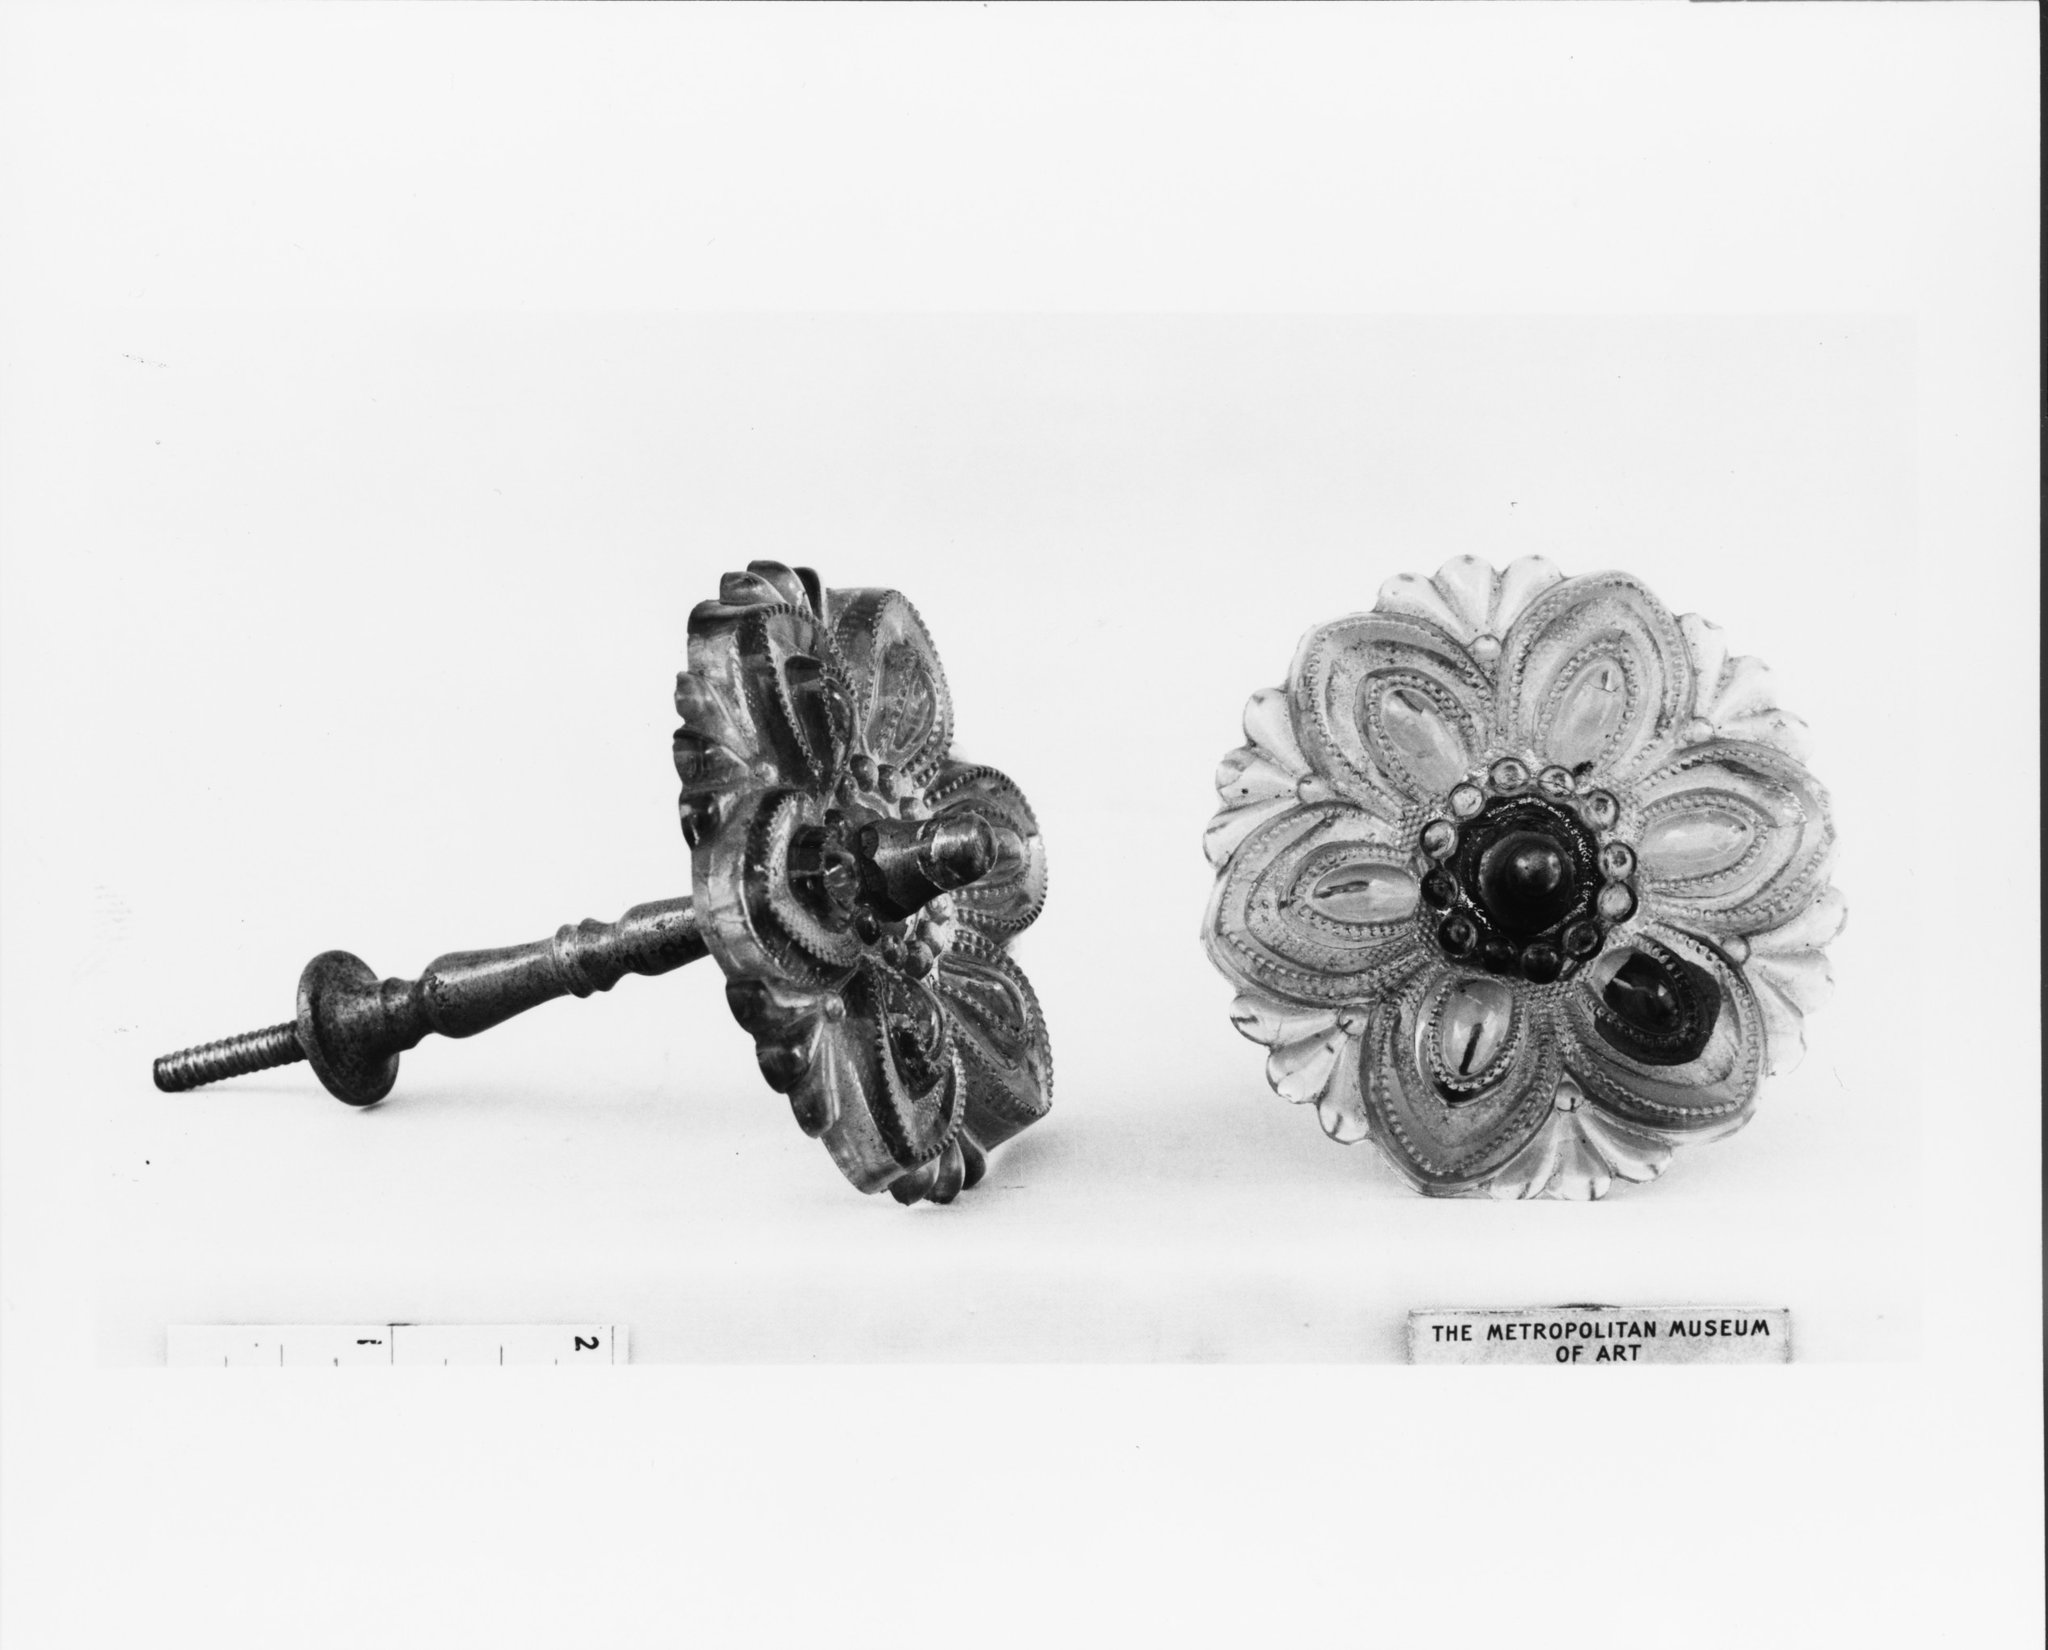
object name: curtain knob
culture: american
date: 1830-1860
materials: brass, glass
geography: united states